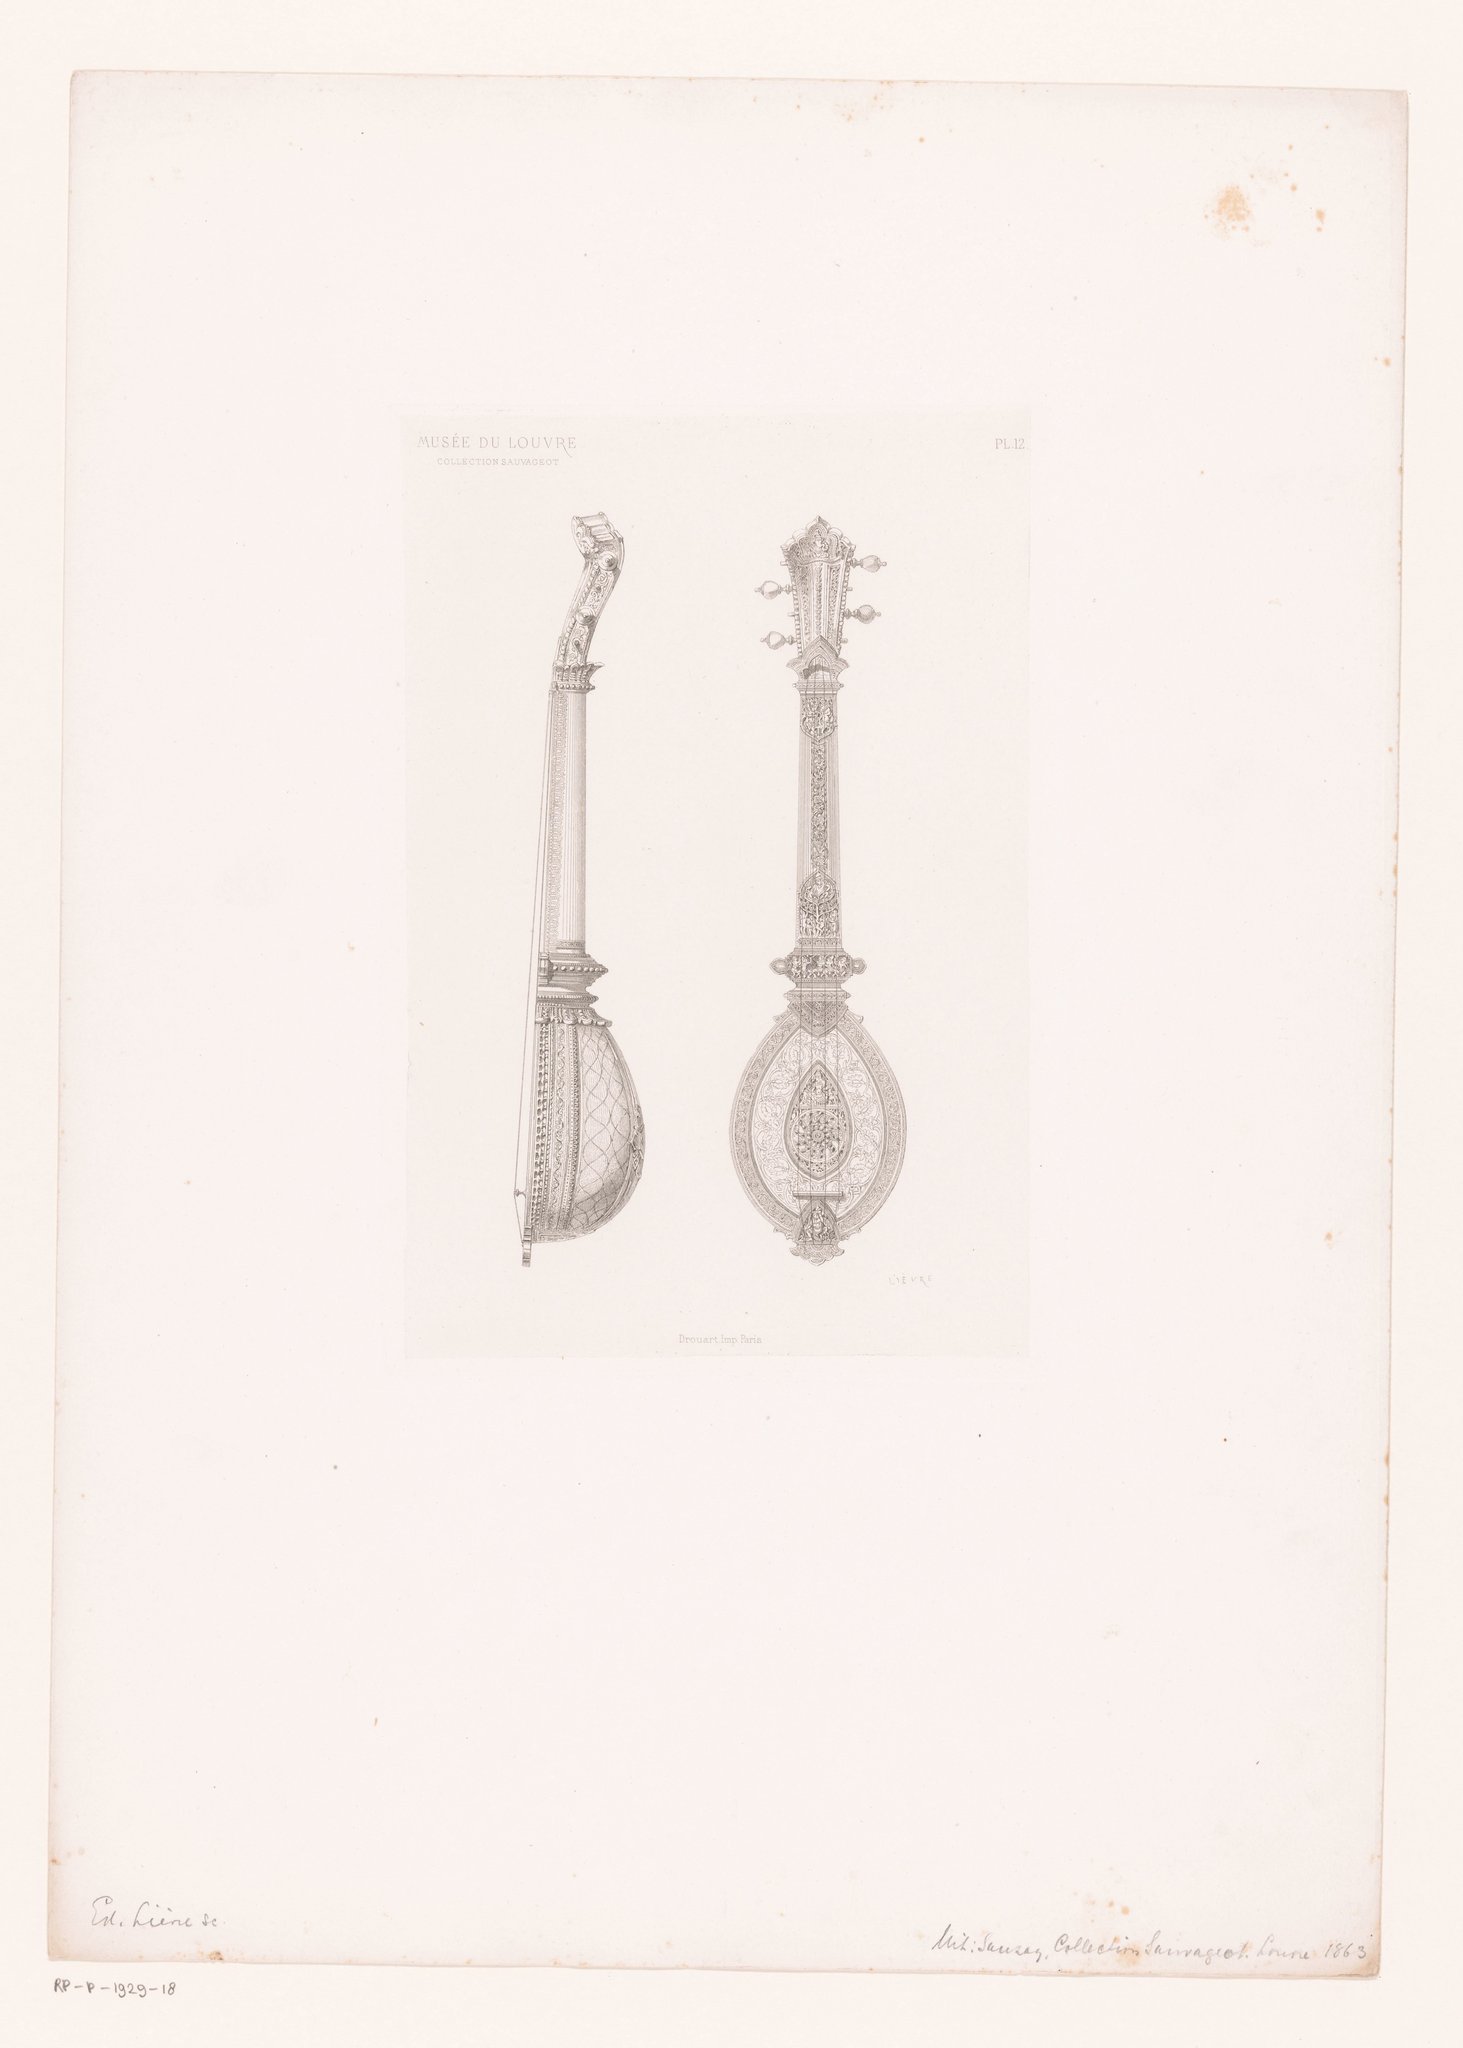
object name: book illustration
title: Twee aanzichten van een snaarinstrument, mogelijk een sitar of bouzouki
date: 1863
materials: paper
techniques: etching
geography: paris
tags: cithern, mandolin, guitar, balalaika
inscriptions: collector's mark: Lugt 2228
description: Prent uit: Sauzay, Alexandre. Musée Impérial Du Louvre - Collection Sauvageot Dessinée Et Gravée A L'Eau-Forte Par Édouard Lièvre Accompagnée D'Un Texte Historique Et Descriptif Par A. Sauzay. Parijs: Noblet et Baudry, 1863. In deze publicatie worden metalen objecten beschreven uit de Gotiek en de Renaissance uit de collectie van Charles Sauvageot, in 1856 geschonken aan het Musée du Louvre.